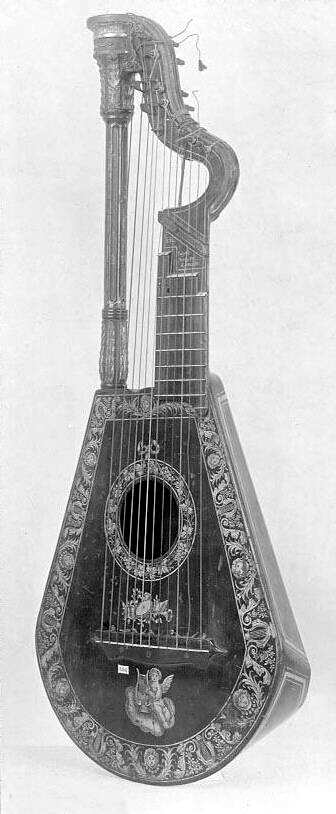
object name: harp lute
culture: british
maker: edward light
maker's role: maker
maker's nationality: british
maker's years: 1747-1832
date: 1800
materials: wood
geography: united kingdom